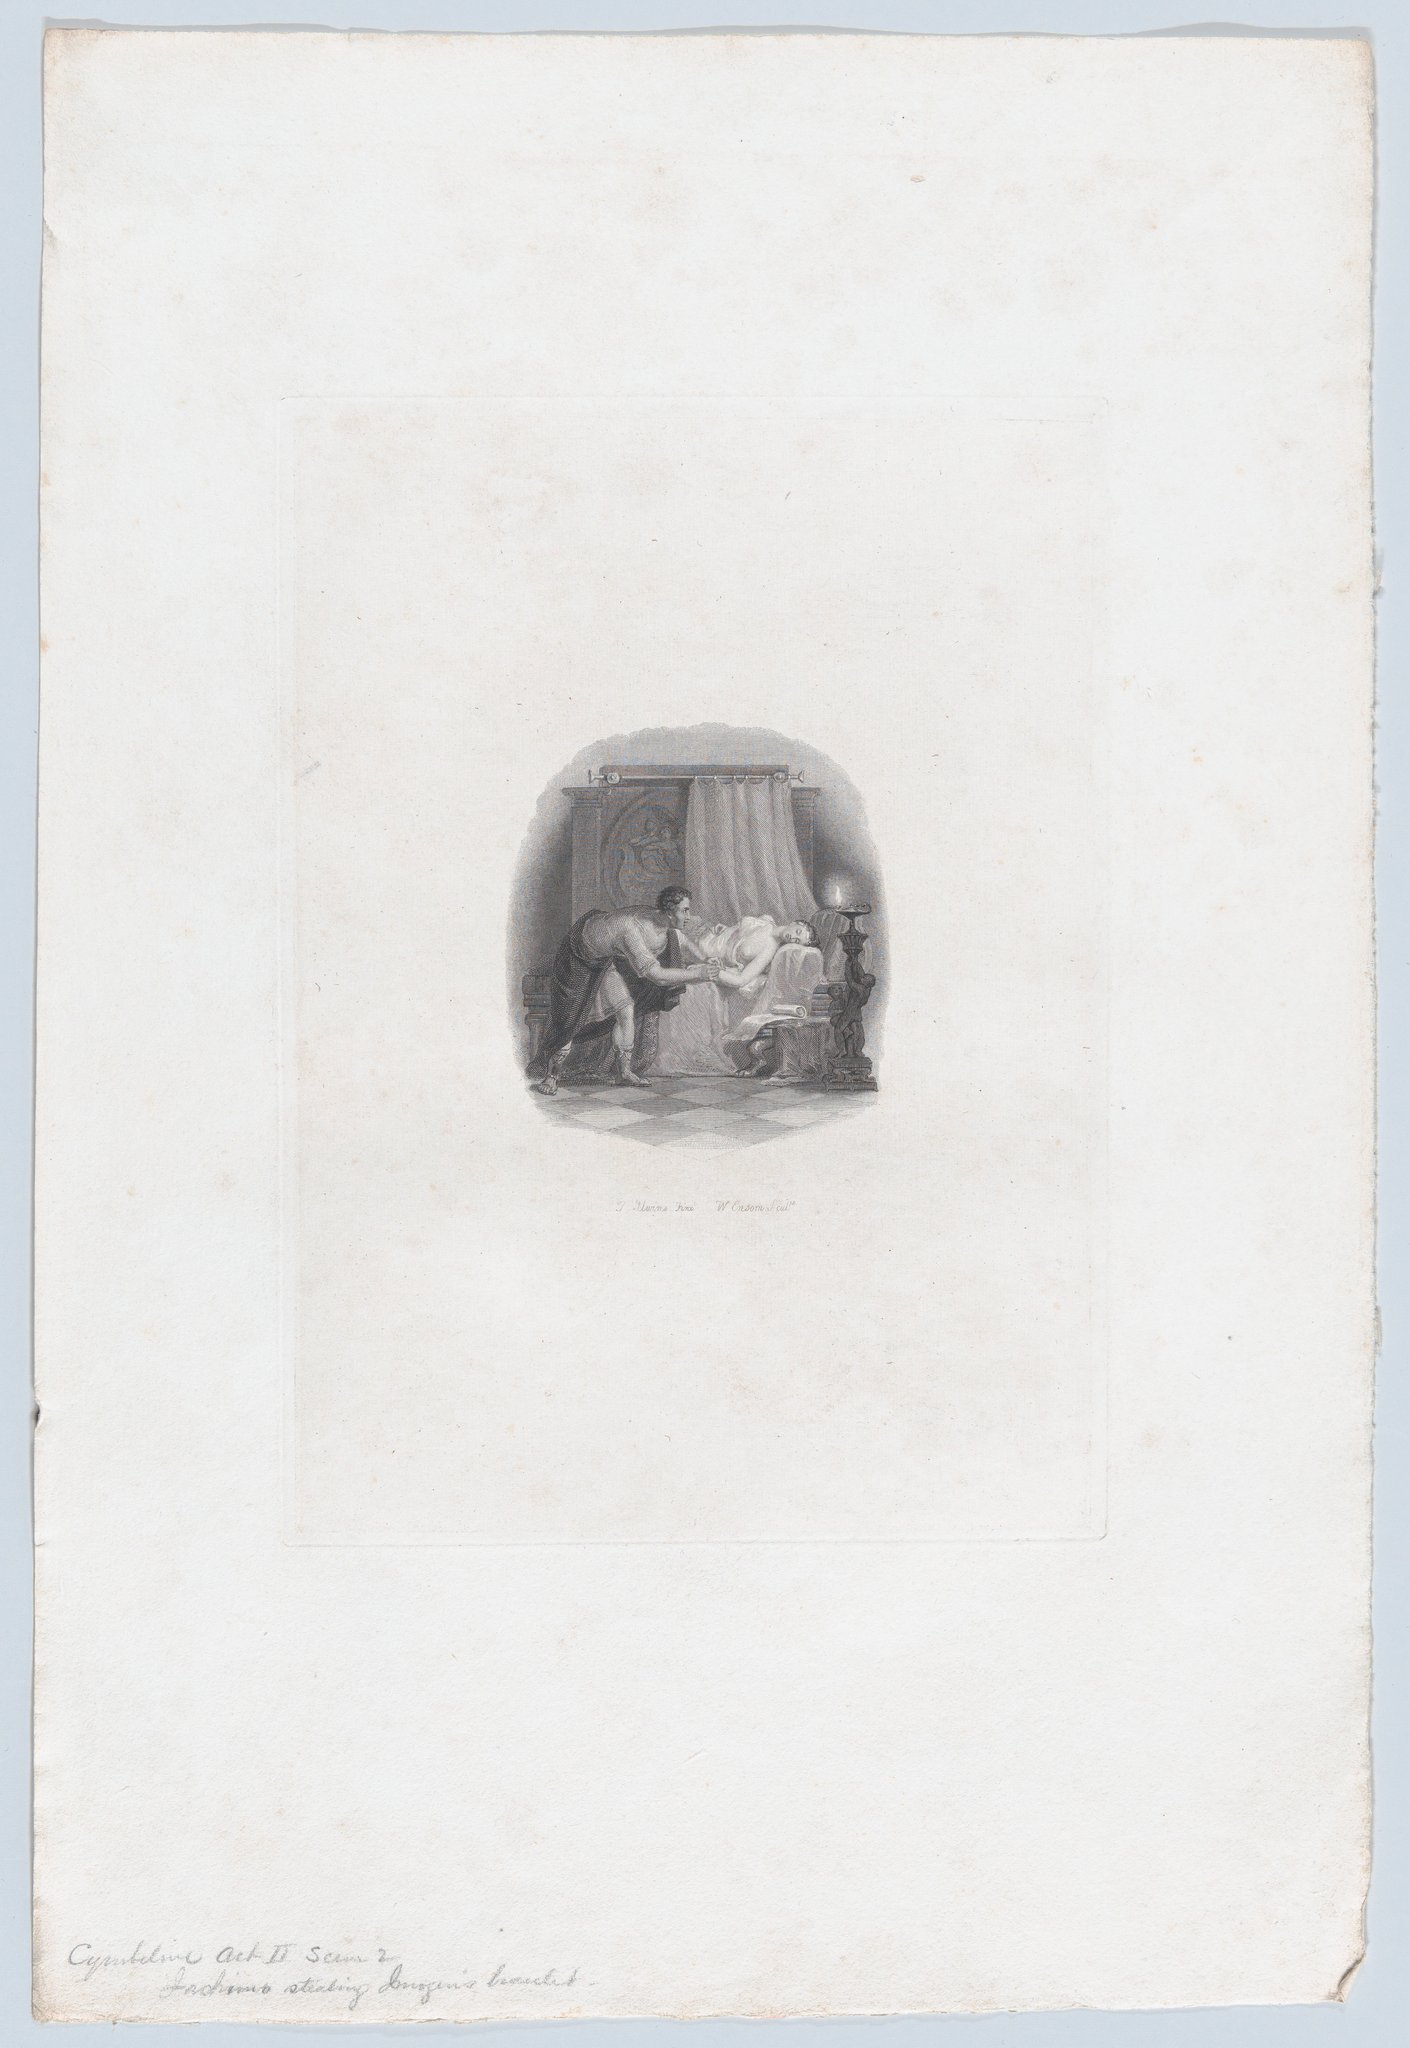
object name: print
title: Imogen and Iachimo (Shakespeare, Cymbeline, Act 2, Scene 2)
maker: william ensom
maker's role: engraver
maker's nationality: british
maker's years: 1796-1832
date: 1827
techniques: printmaking, engraving, etching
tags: shakespeare,men,women